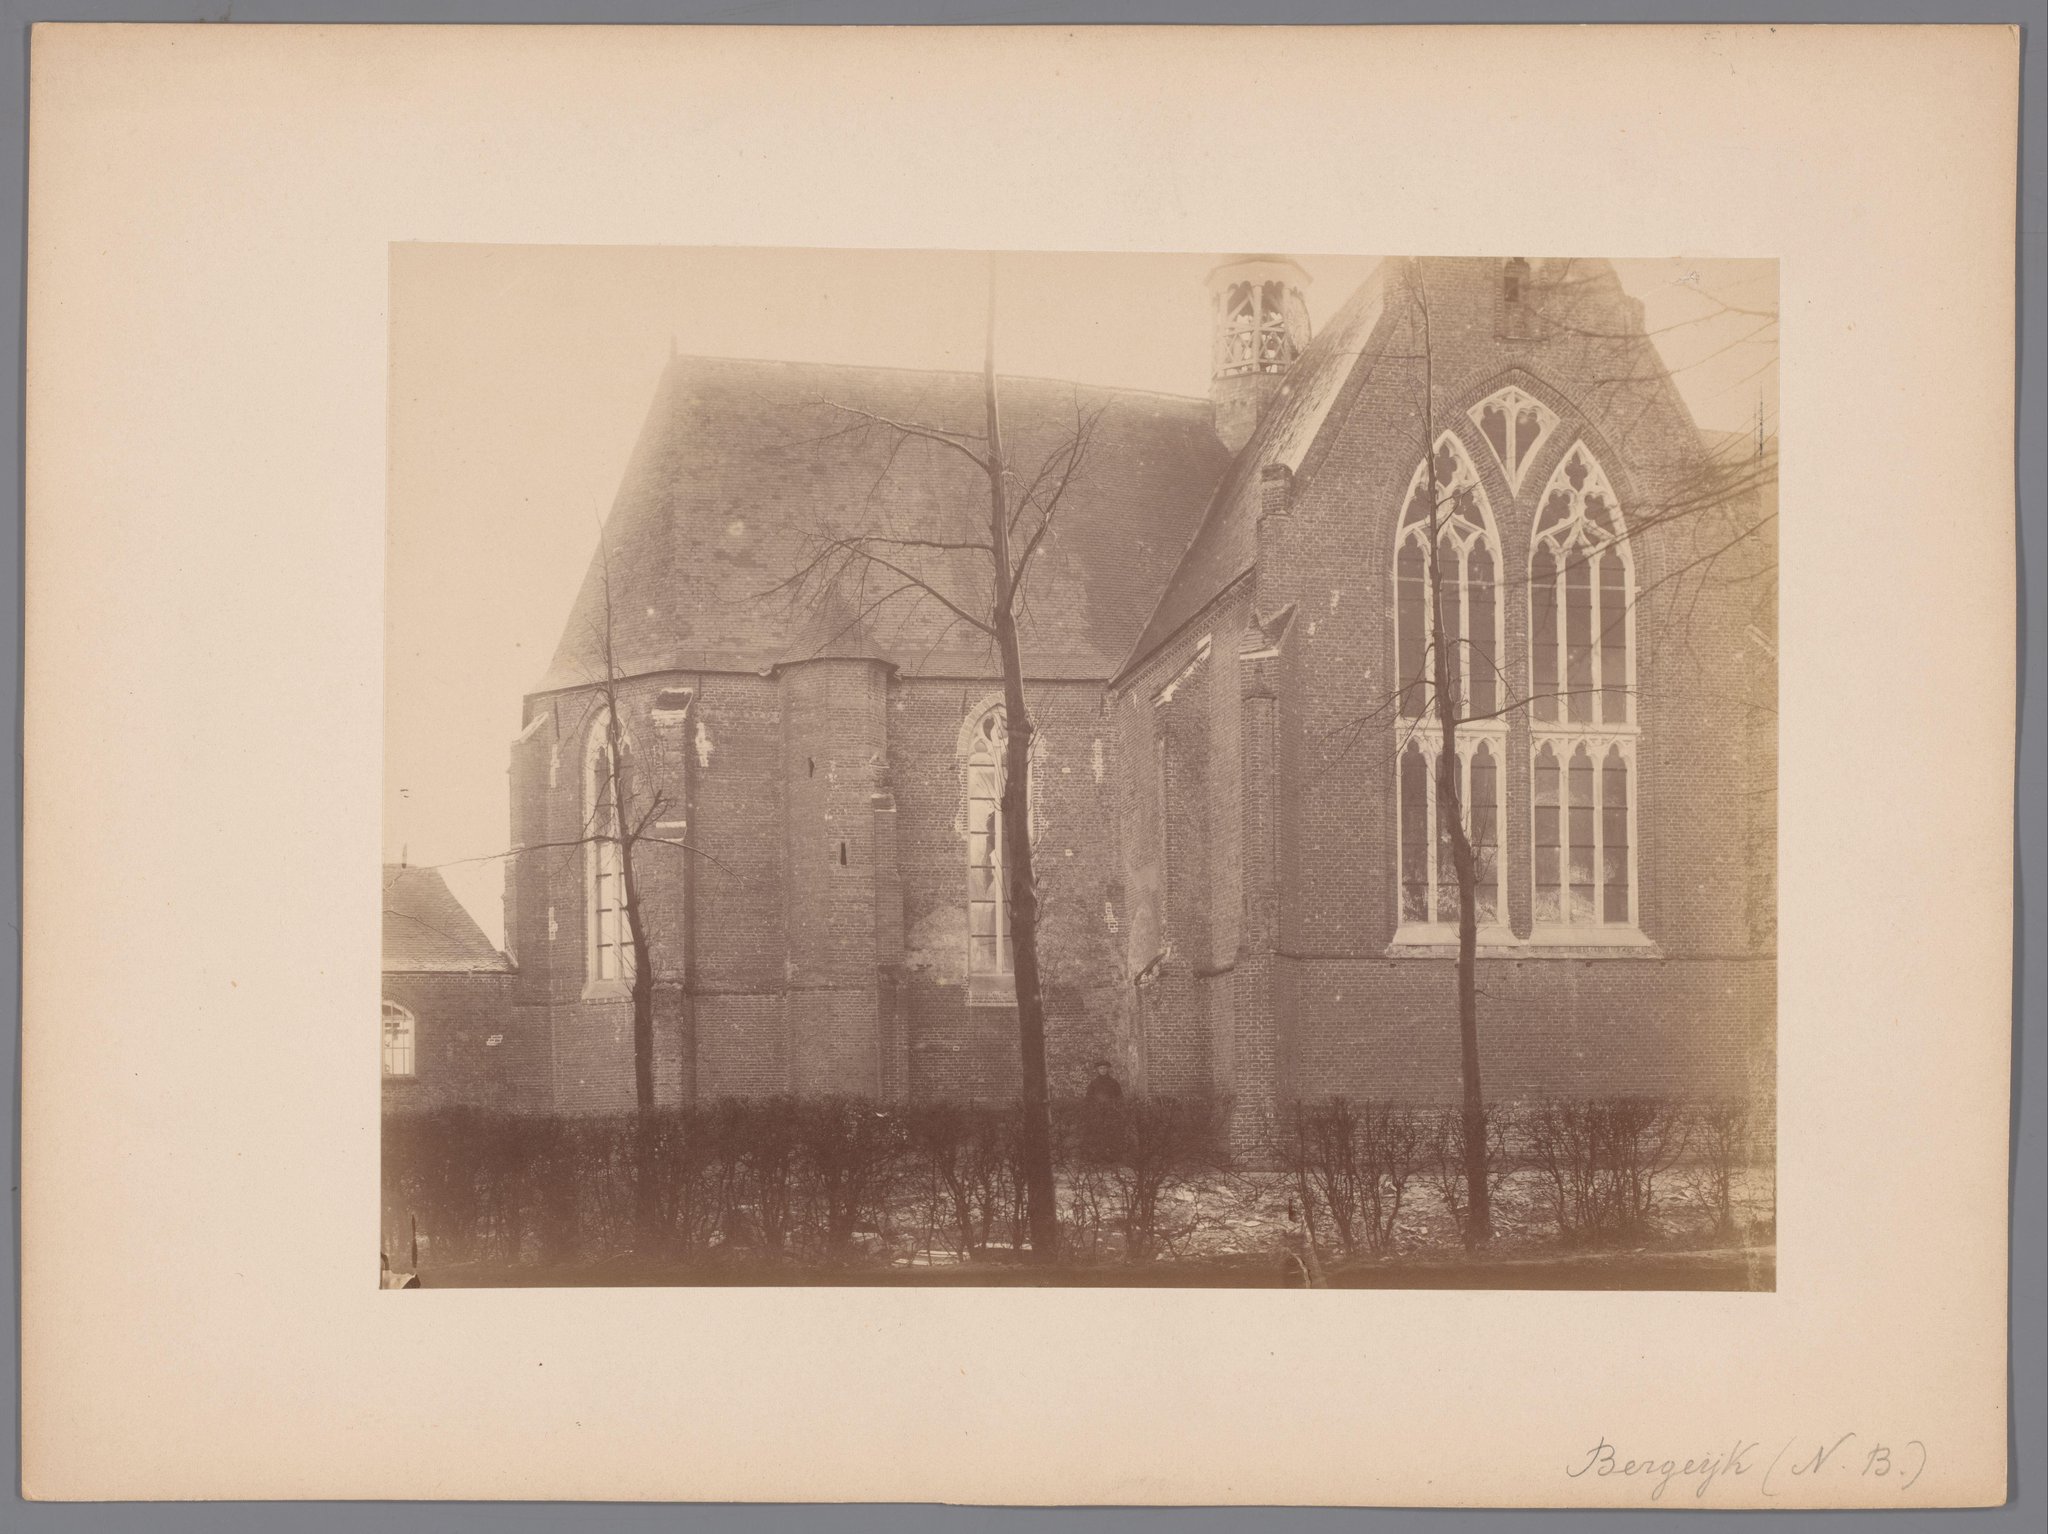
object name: photograph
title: Noordoostzijde van St. Petrus' Bandenkerk of Hofkerk te Bergeijk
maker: anoniem (monumentenzorg)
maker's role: fotograaf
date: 1890-1920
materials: cardboard, photographic support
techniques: albumen print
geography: bergeijk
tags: church (exterior)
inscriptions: annotation: ‘Bergeijk N.B./ N.O. zijde kerk’, annotation: ‘Bergeijk (N.B.)’